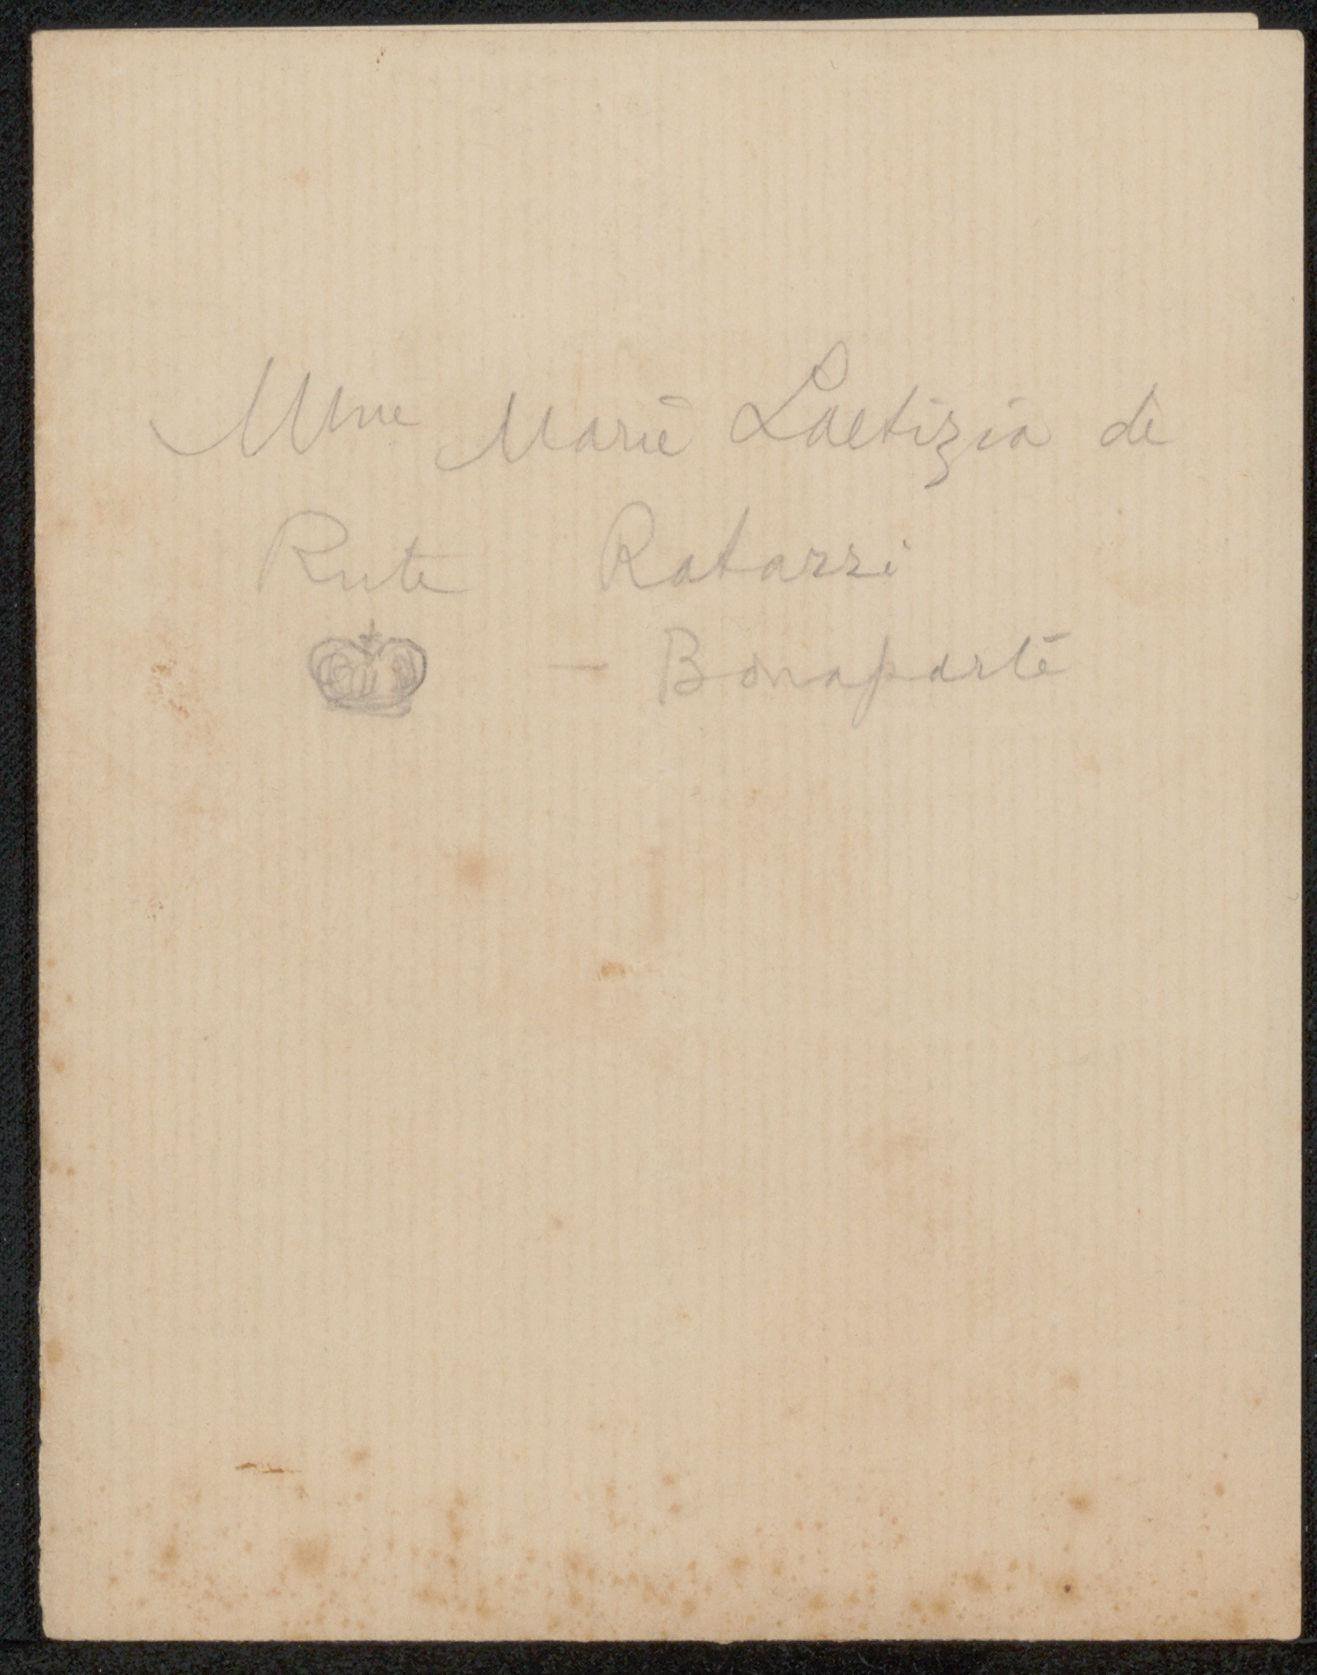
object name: aantekening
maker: philip zilcken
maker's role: draughtsman, painter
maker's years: 1857-1930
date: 1867-1930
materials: paper, pencil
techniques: writing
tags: paris, marie-lætitia bonaparte-wyse, crown (symbol of sovereignty)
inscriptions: collector's mark: ‘RPK’